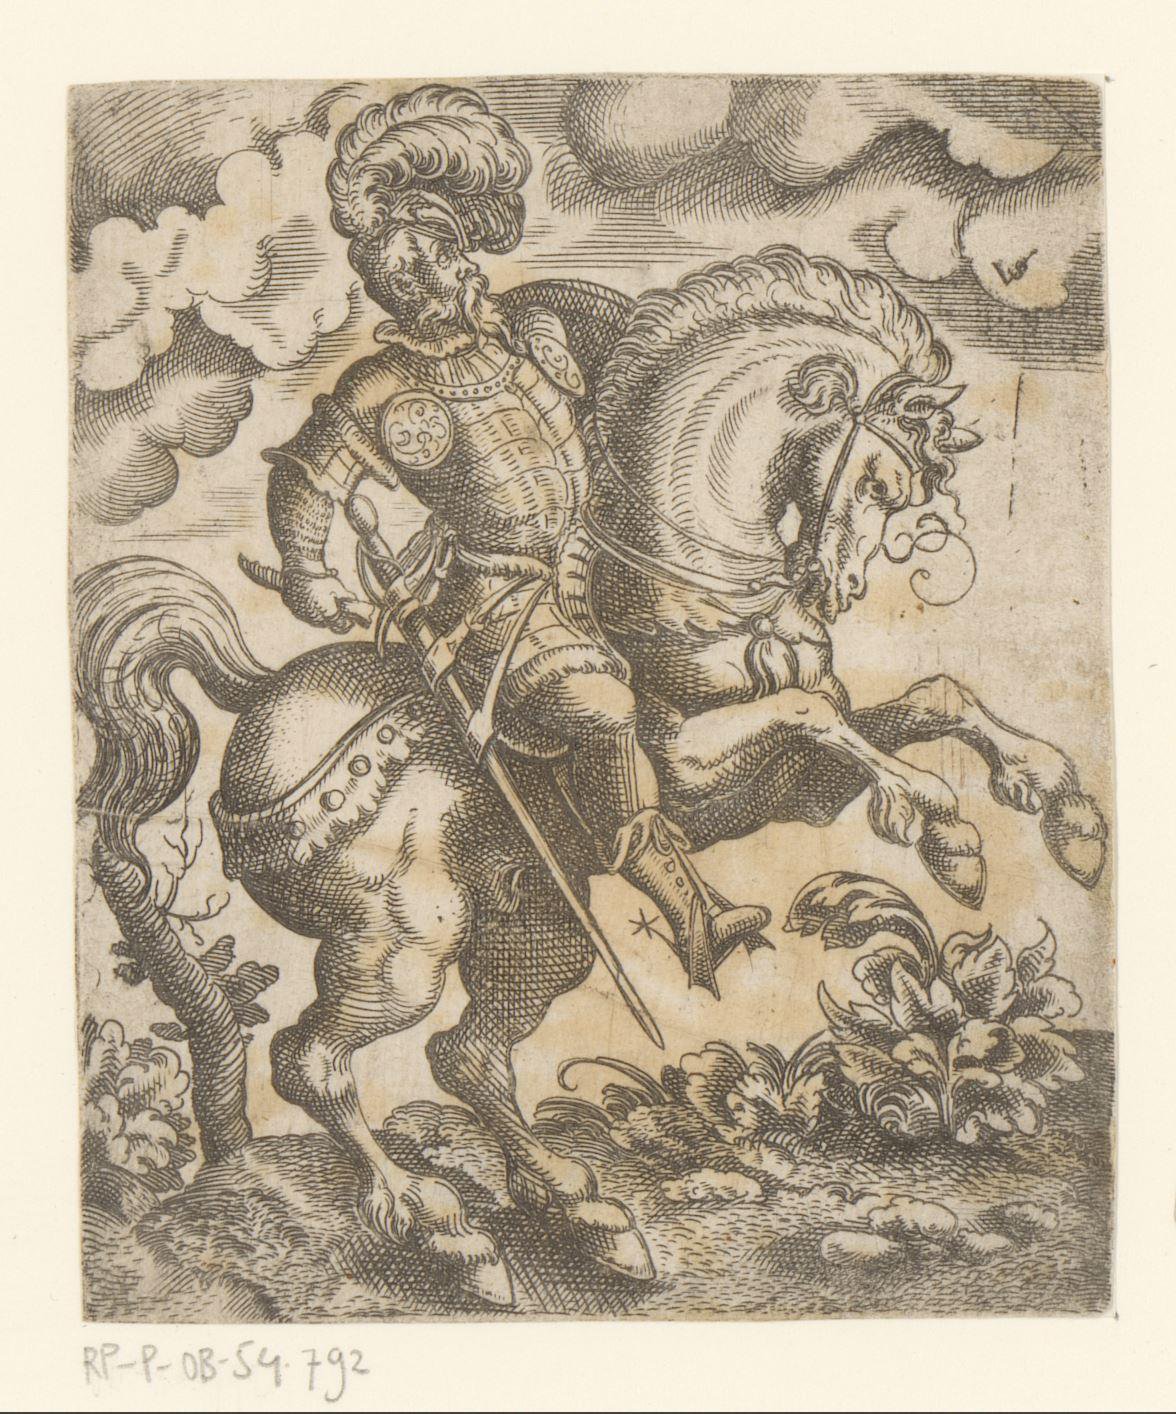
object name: print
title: Landsknechten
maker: virgilius solis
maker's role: draughtsman, print maker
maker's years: 1514-1562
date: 1524-1562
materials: paper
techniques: engraving, etching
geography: nuremberg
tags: riding a horse, ass, or mule; rider, horseman, ranks in the army, the soldier; the soldier's life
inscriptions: number: ‘146’, collector's mark: Lugt 2228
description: Maakt deel uit van een serie van zeven prenten met landsknechten.